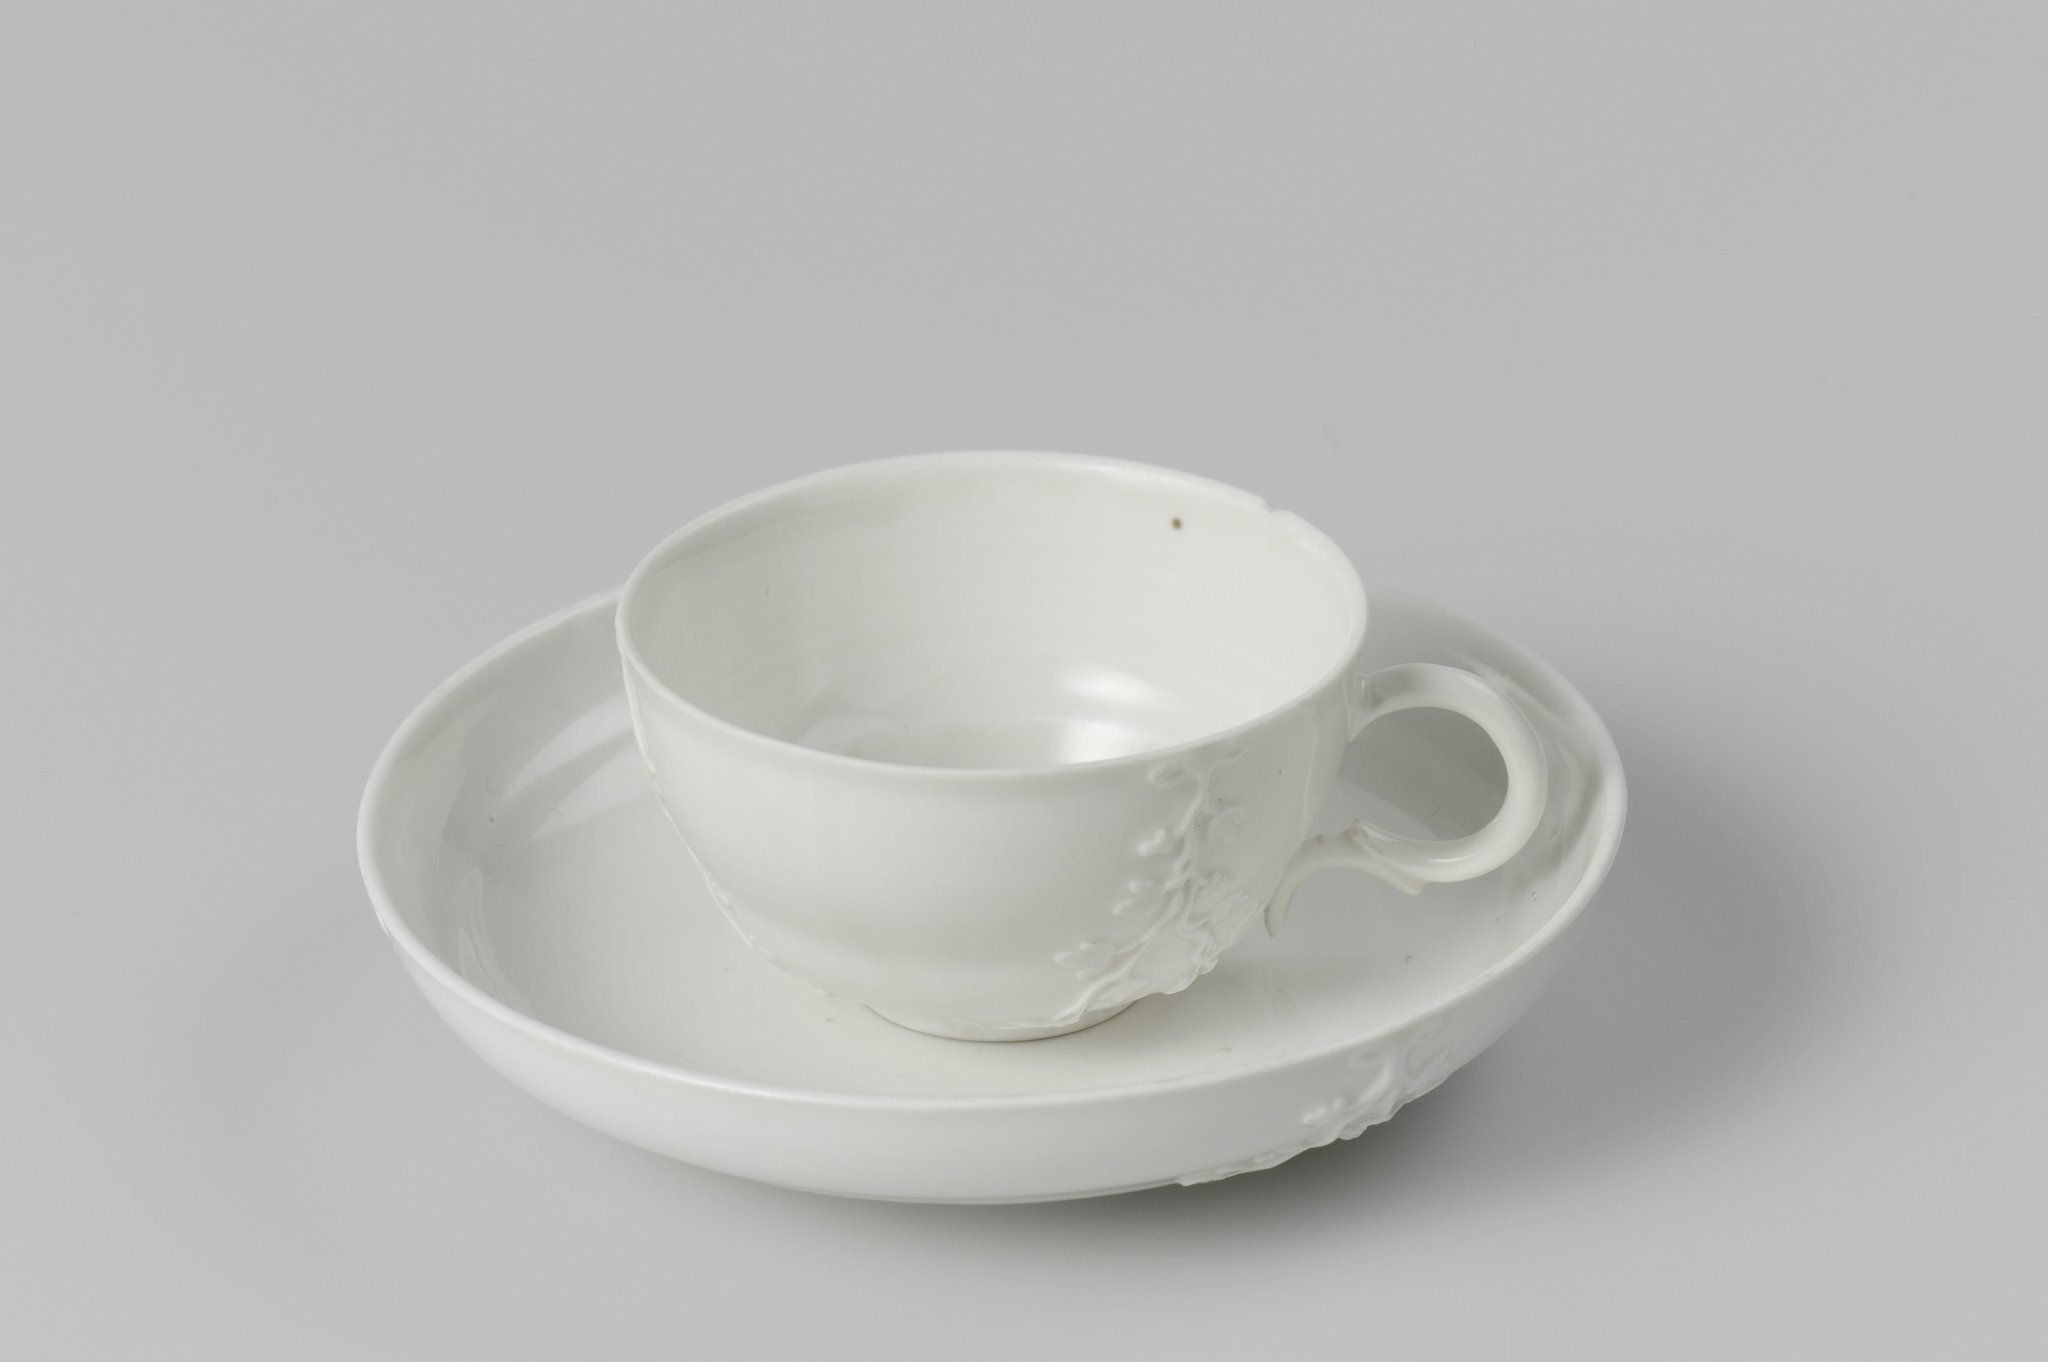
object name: kop en schotel, kop en schotel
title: Cup and saucer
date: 1759-1771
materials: porcelain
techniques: painted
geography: weesp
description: Weesper porseleinfabriek Weesp, c. 1759–1771 hard-paste porcelain